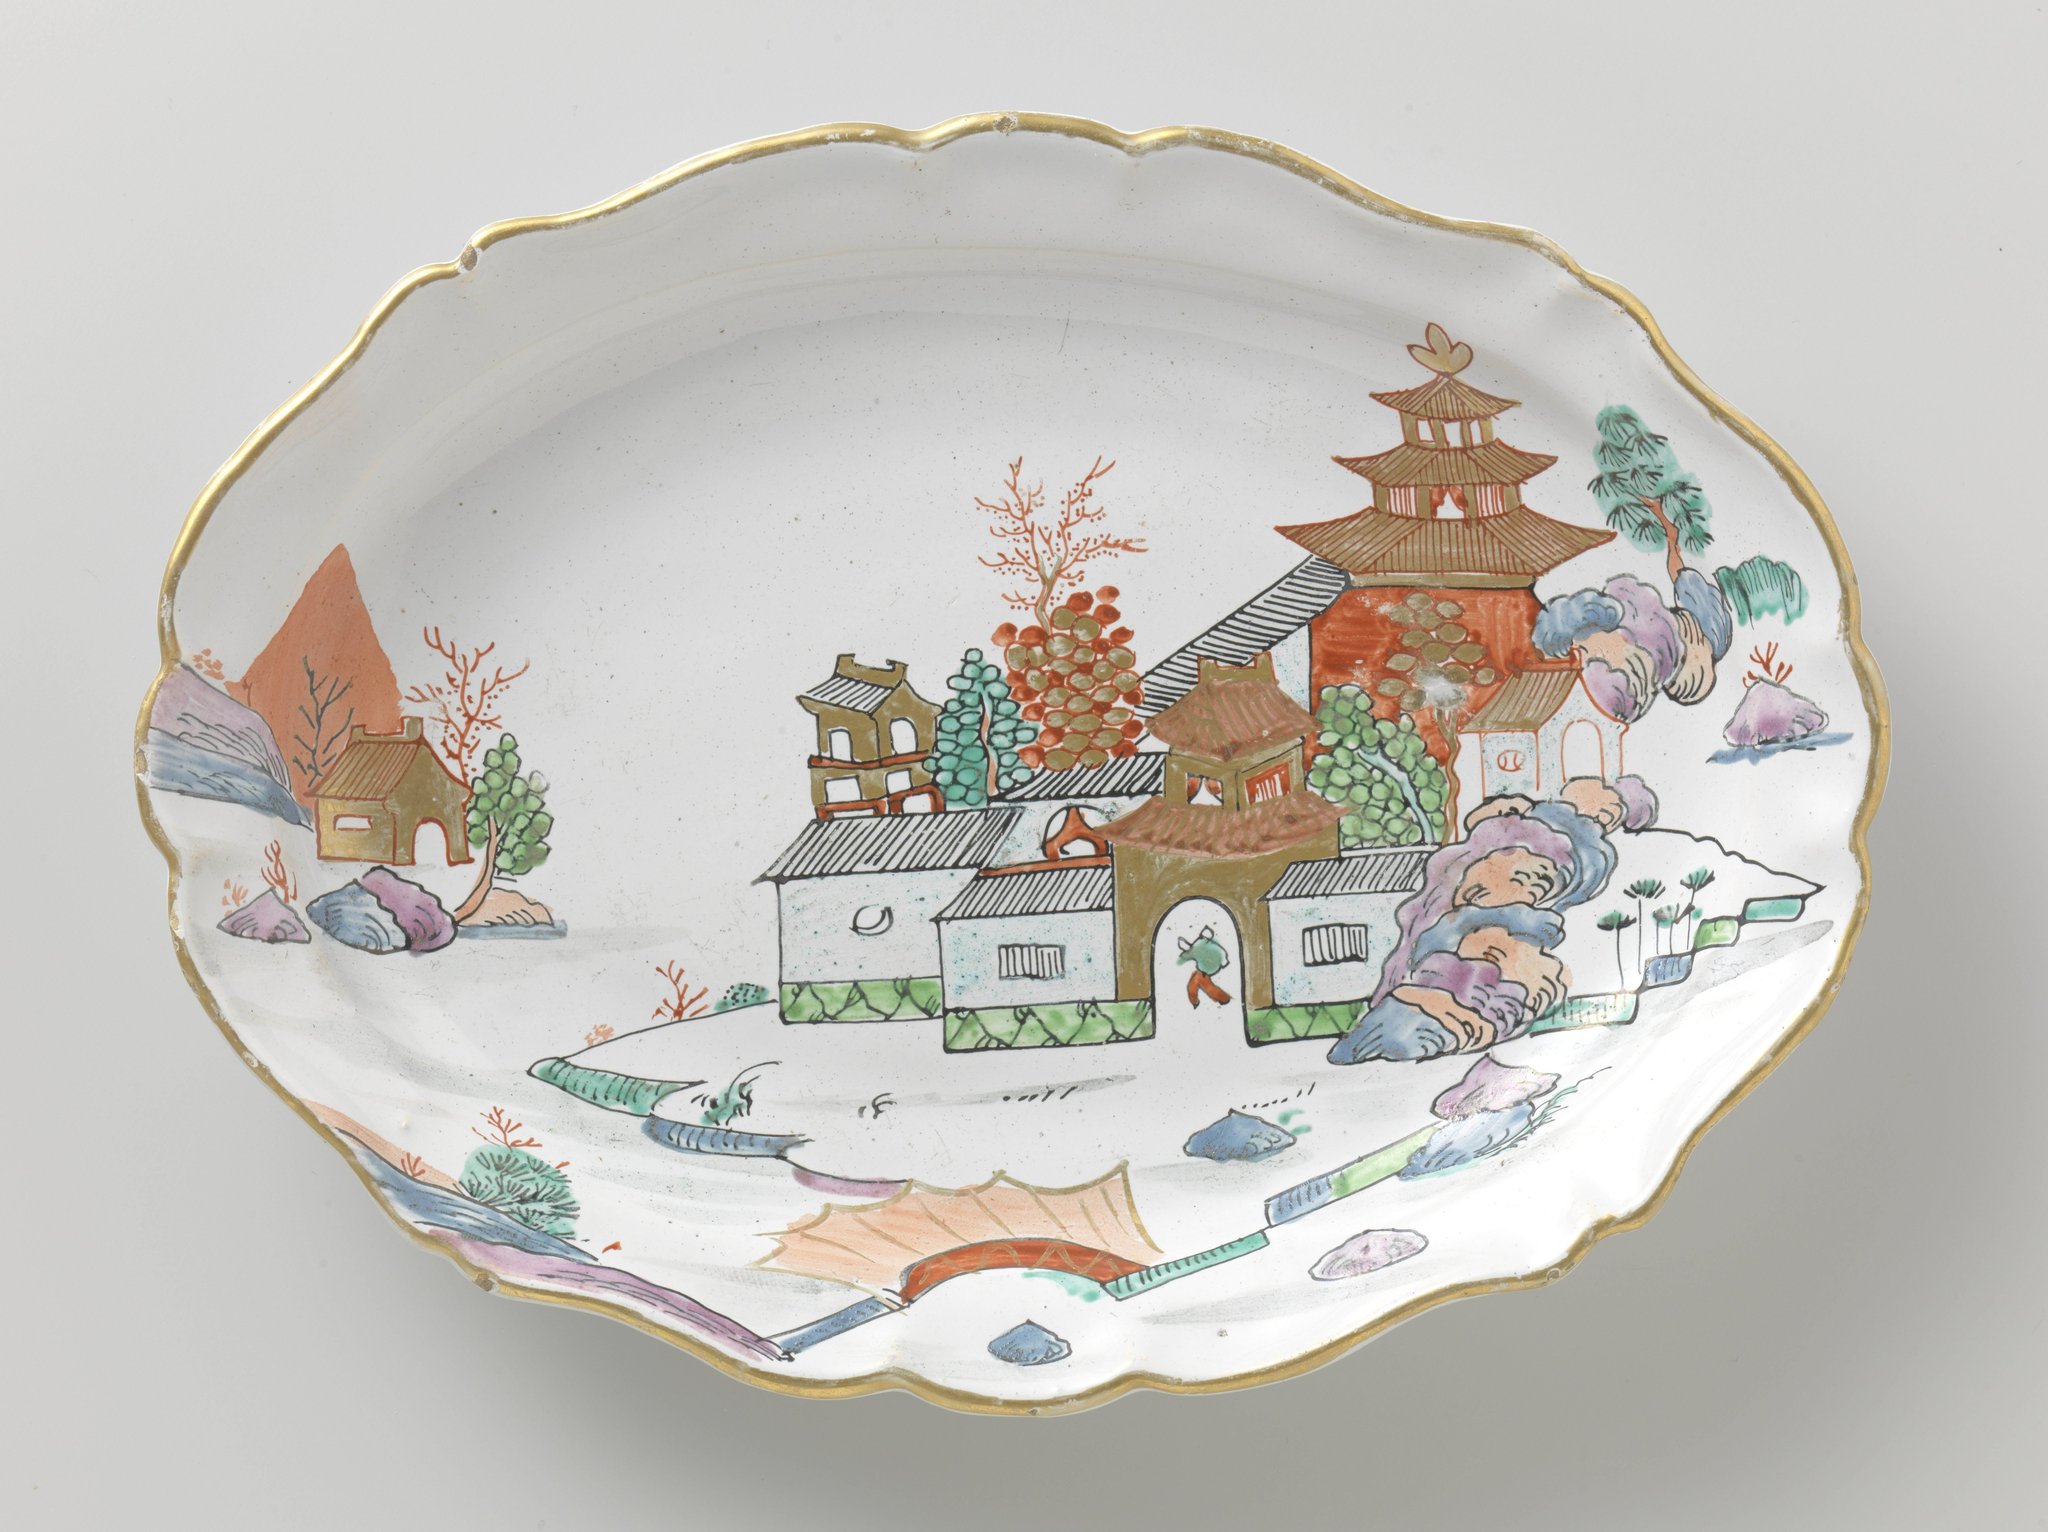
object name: platter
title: Onderschotel, beschilderd met oosters landschap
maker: jacobus adriaens halder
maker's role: fayencier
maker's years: 1741-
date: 1765-1768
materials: faience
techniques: kiln, painted, polychromy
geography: delft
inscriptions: mark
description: Onderschotel van botervloot met deksel.(B en C). Veelkleurig versierd met een oosters landschap met rotsen en gebouwen. Gemerkt in zwart A/IH.